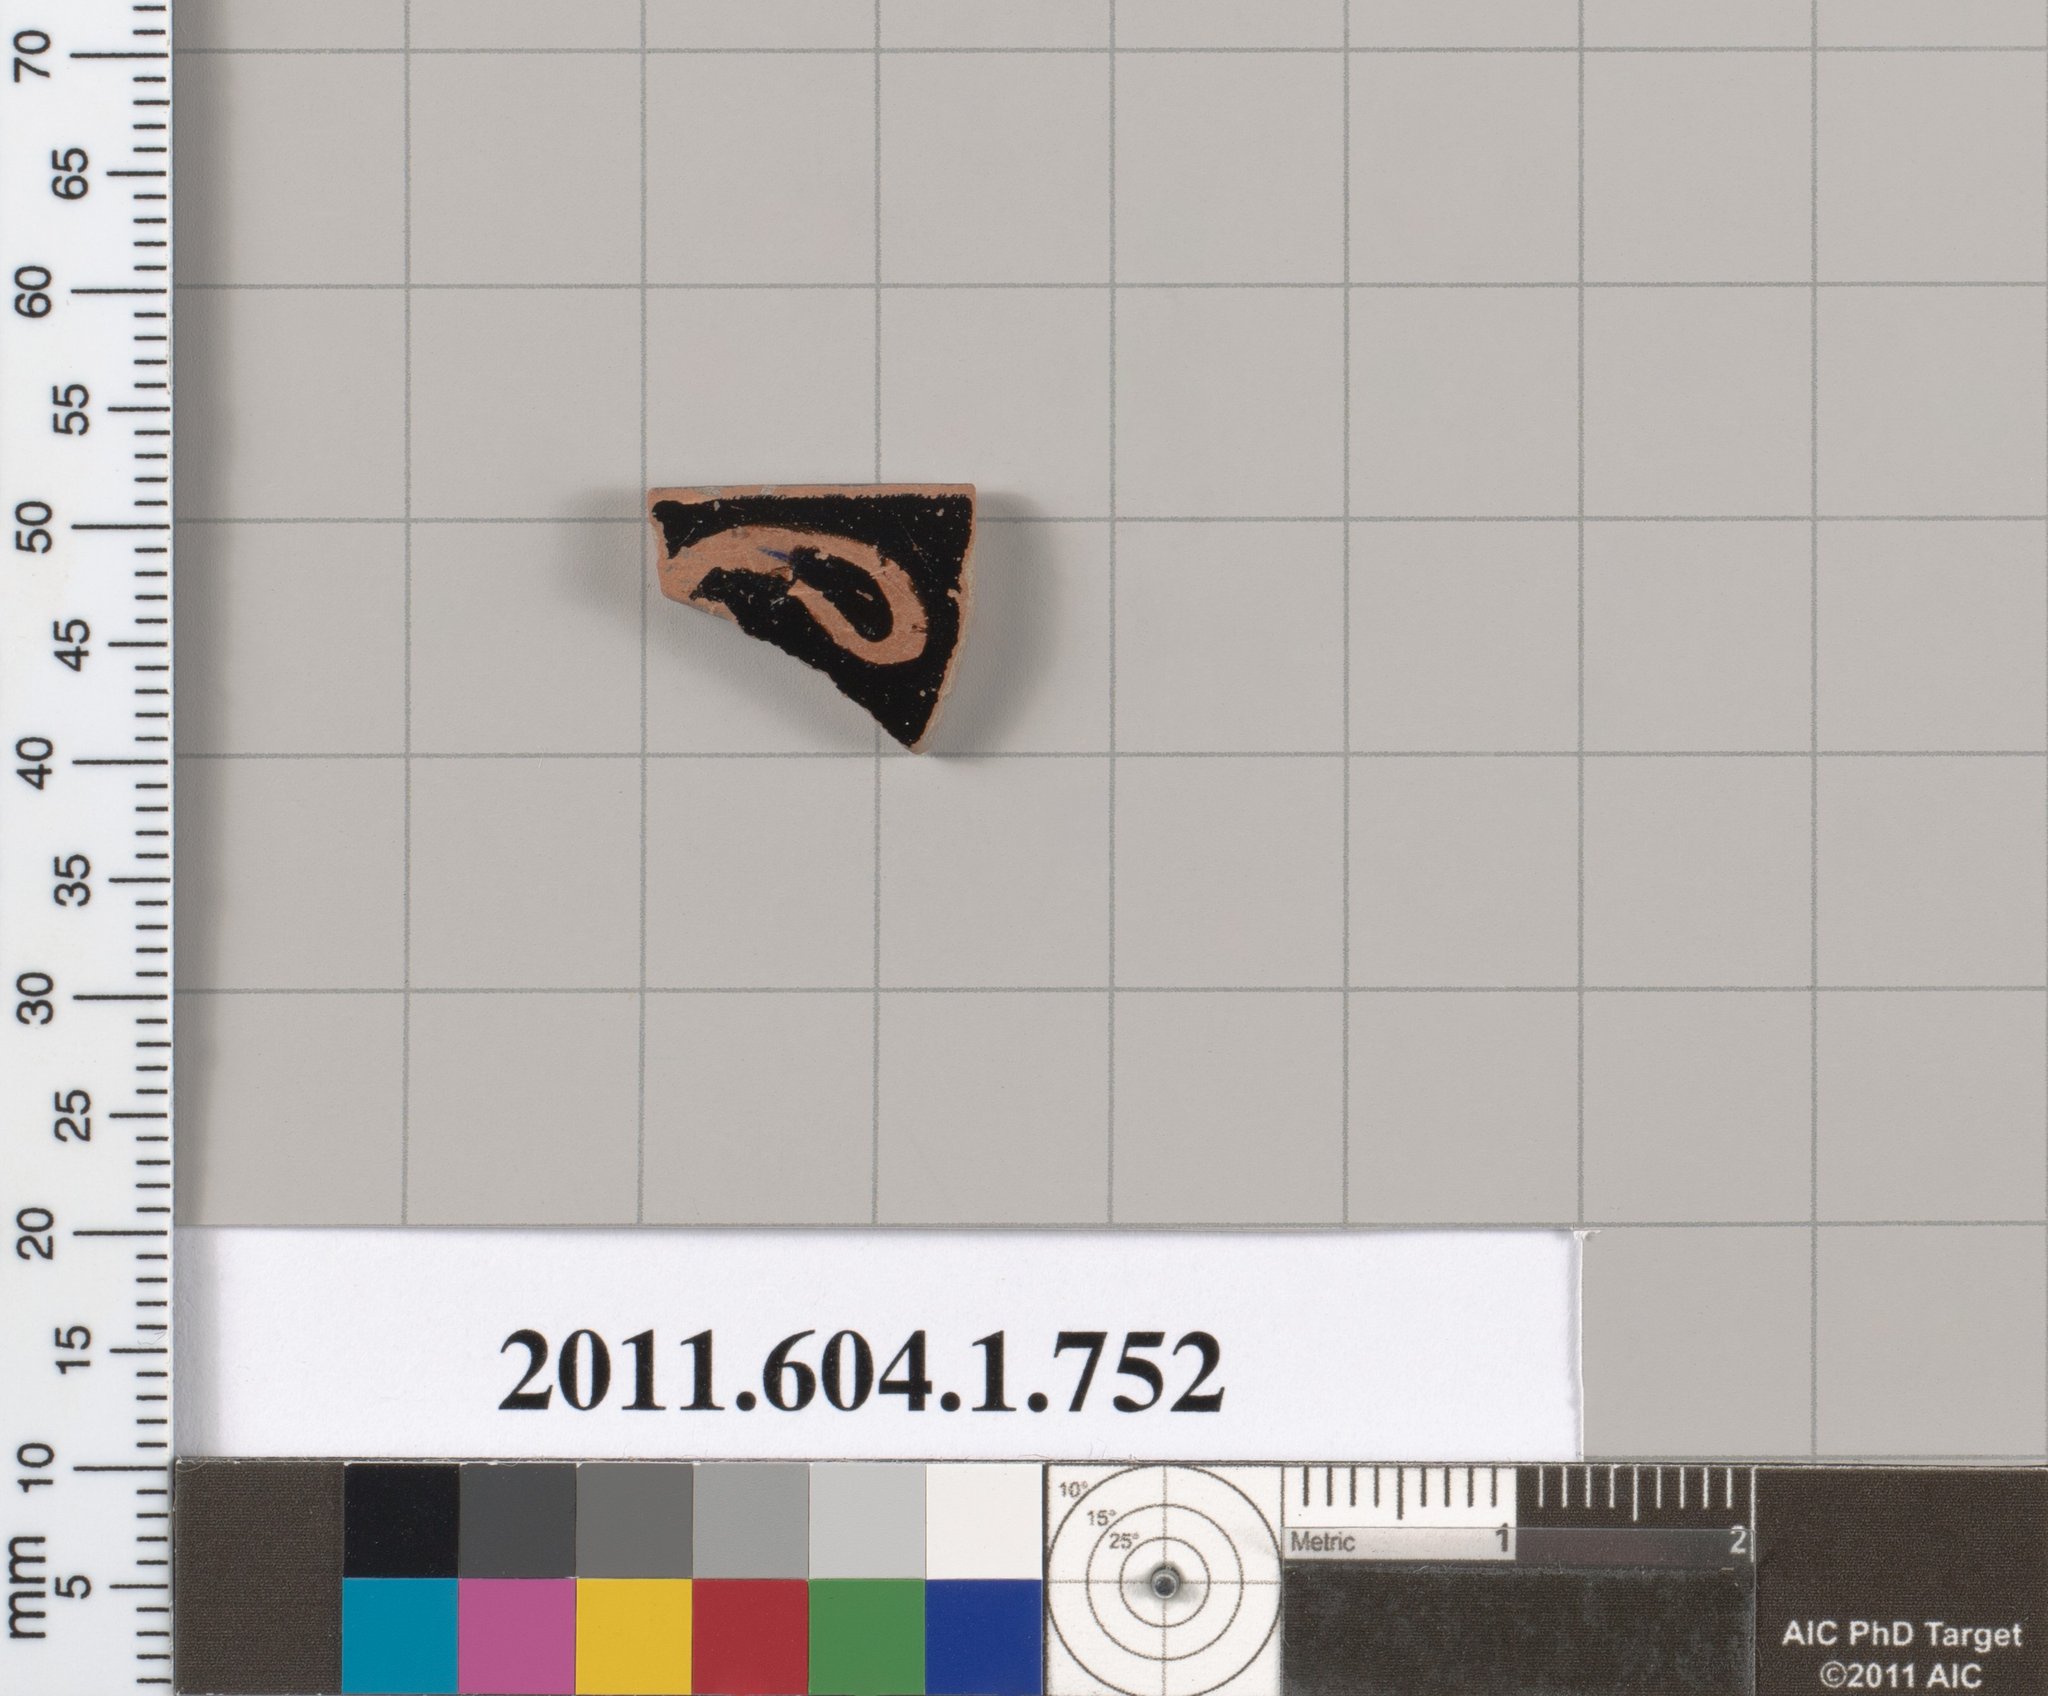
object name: terracotta fragment of a kylix drinking cup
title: Terracotta rim fragment of a kylix (drinking cup)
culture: greek, attic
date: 475-451 BCE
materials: terracotta